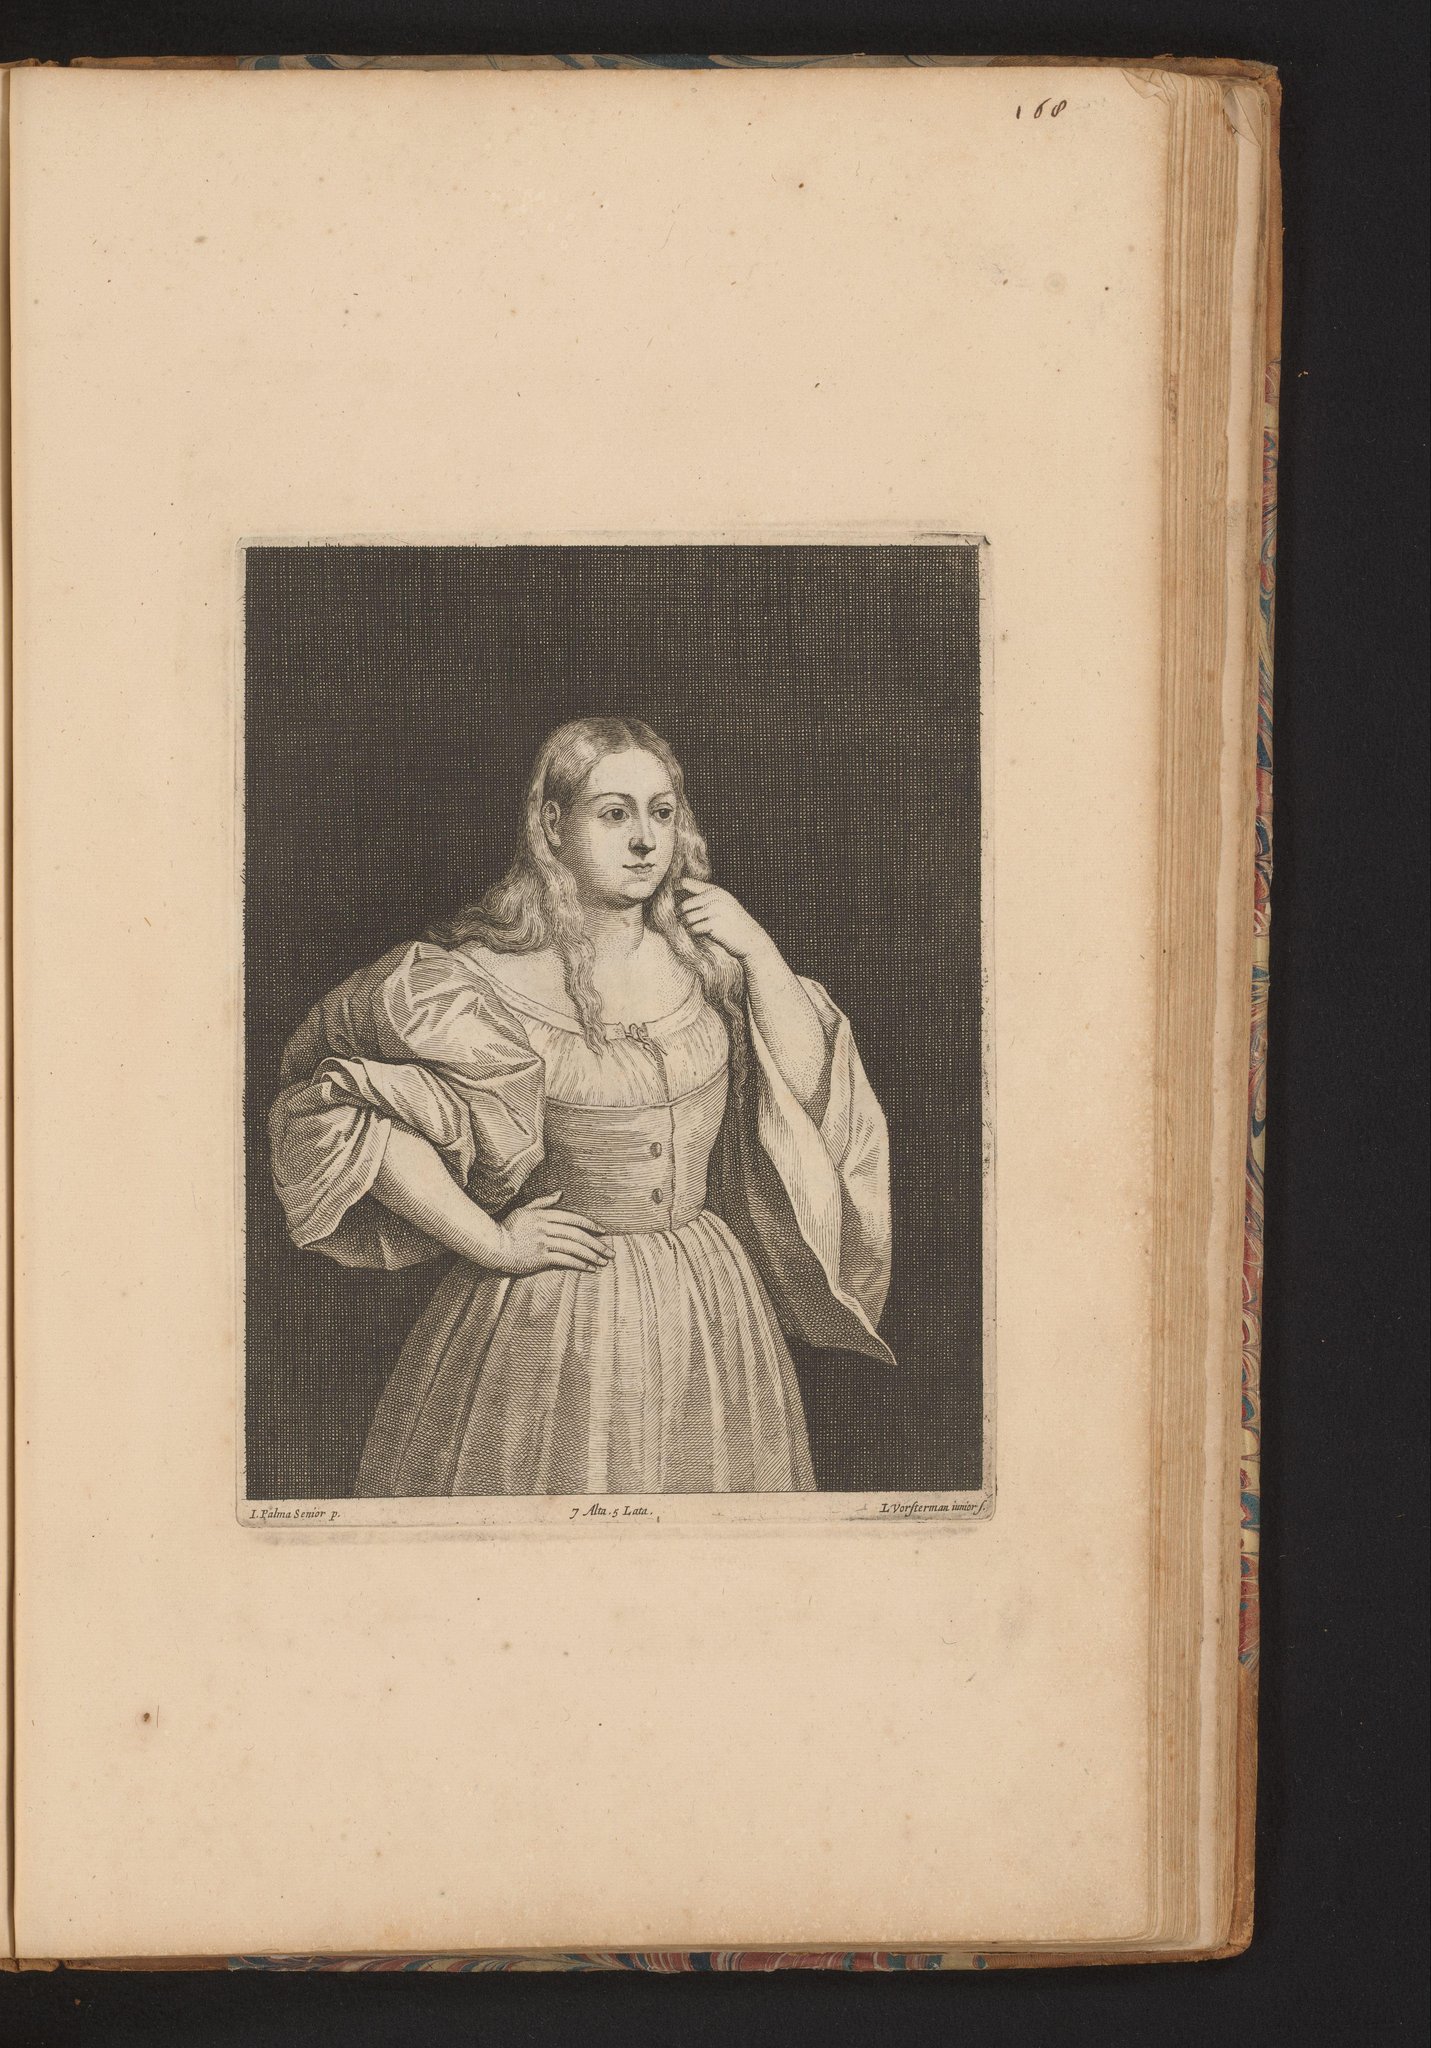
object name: album leaf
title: Portret van een onbekende jonge vrouw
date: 1660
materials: paper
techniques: etching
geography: antwerp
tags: anonymous historical person portrayed - bb - woman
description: David Teniers heeft waarschijnlijk van alle schilderijen uit de collectie van Leopold Willem van Oostenrijk een olieverfstudie op doek of paneel vervaardigd (zgn. pasticcio), die als voorbeeld voor de prentmakers diende. Het is niet altijd duidelijk of de pasticci door hem zijn gemaakt of door zijn atelier. Niet alle pasticci zijn overgeleverd.